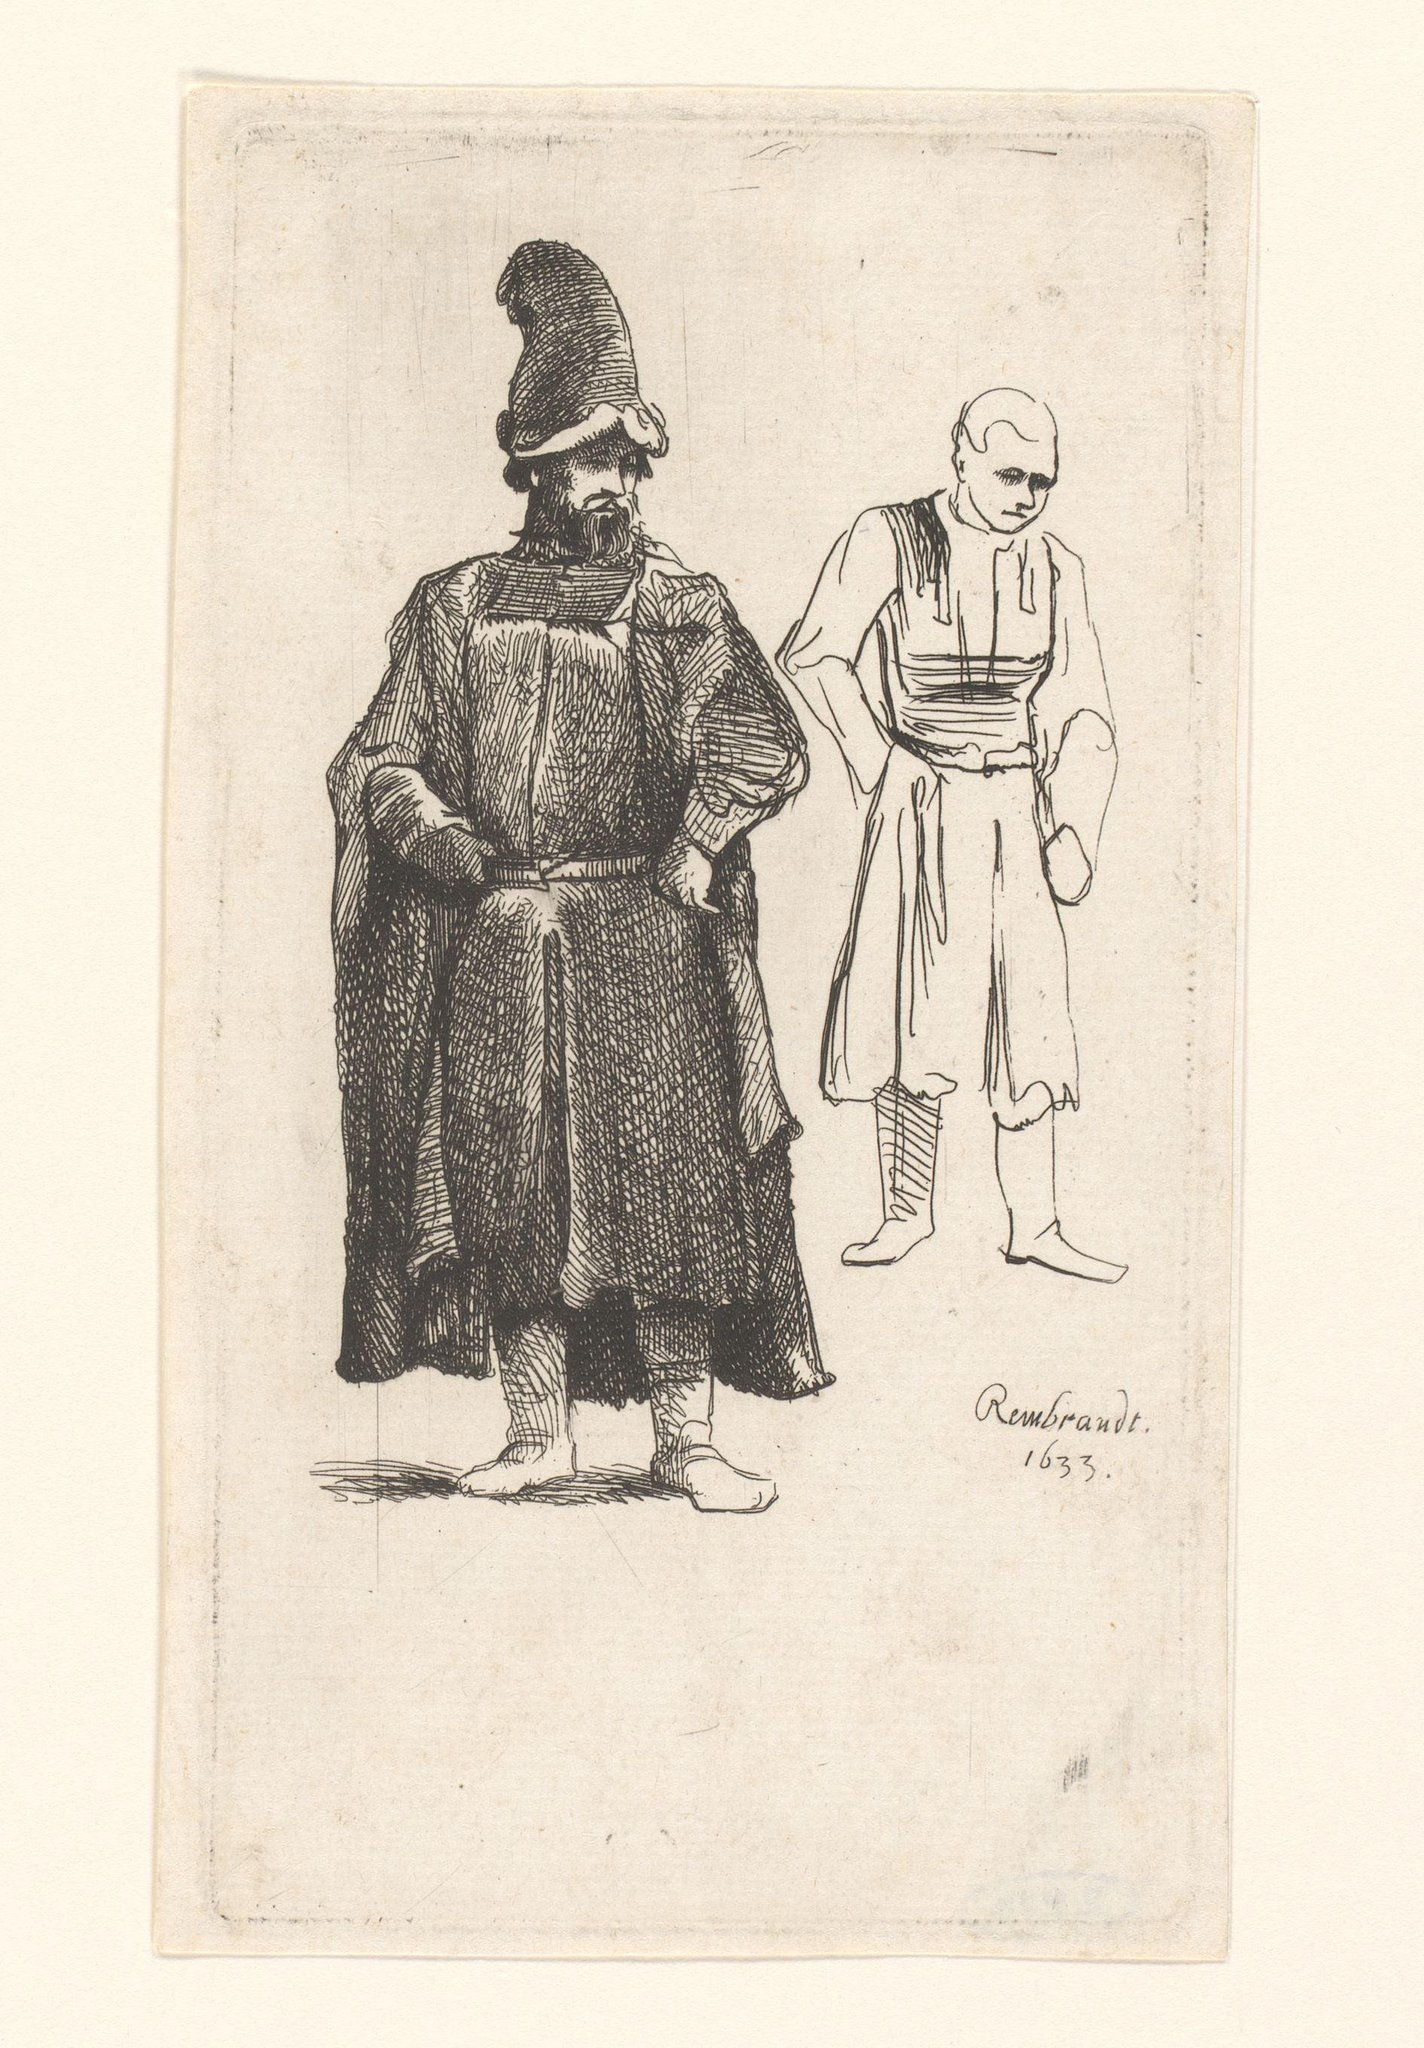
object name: print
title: Twee staande figuren, mogelijk krijgsmannen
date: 1700-1799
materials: paper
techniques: etching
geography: netherlands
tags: standing figure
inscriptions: collector's mark: Lugt 2228